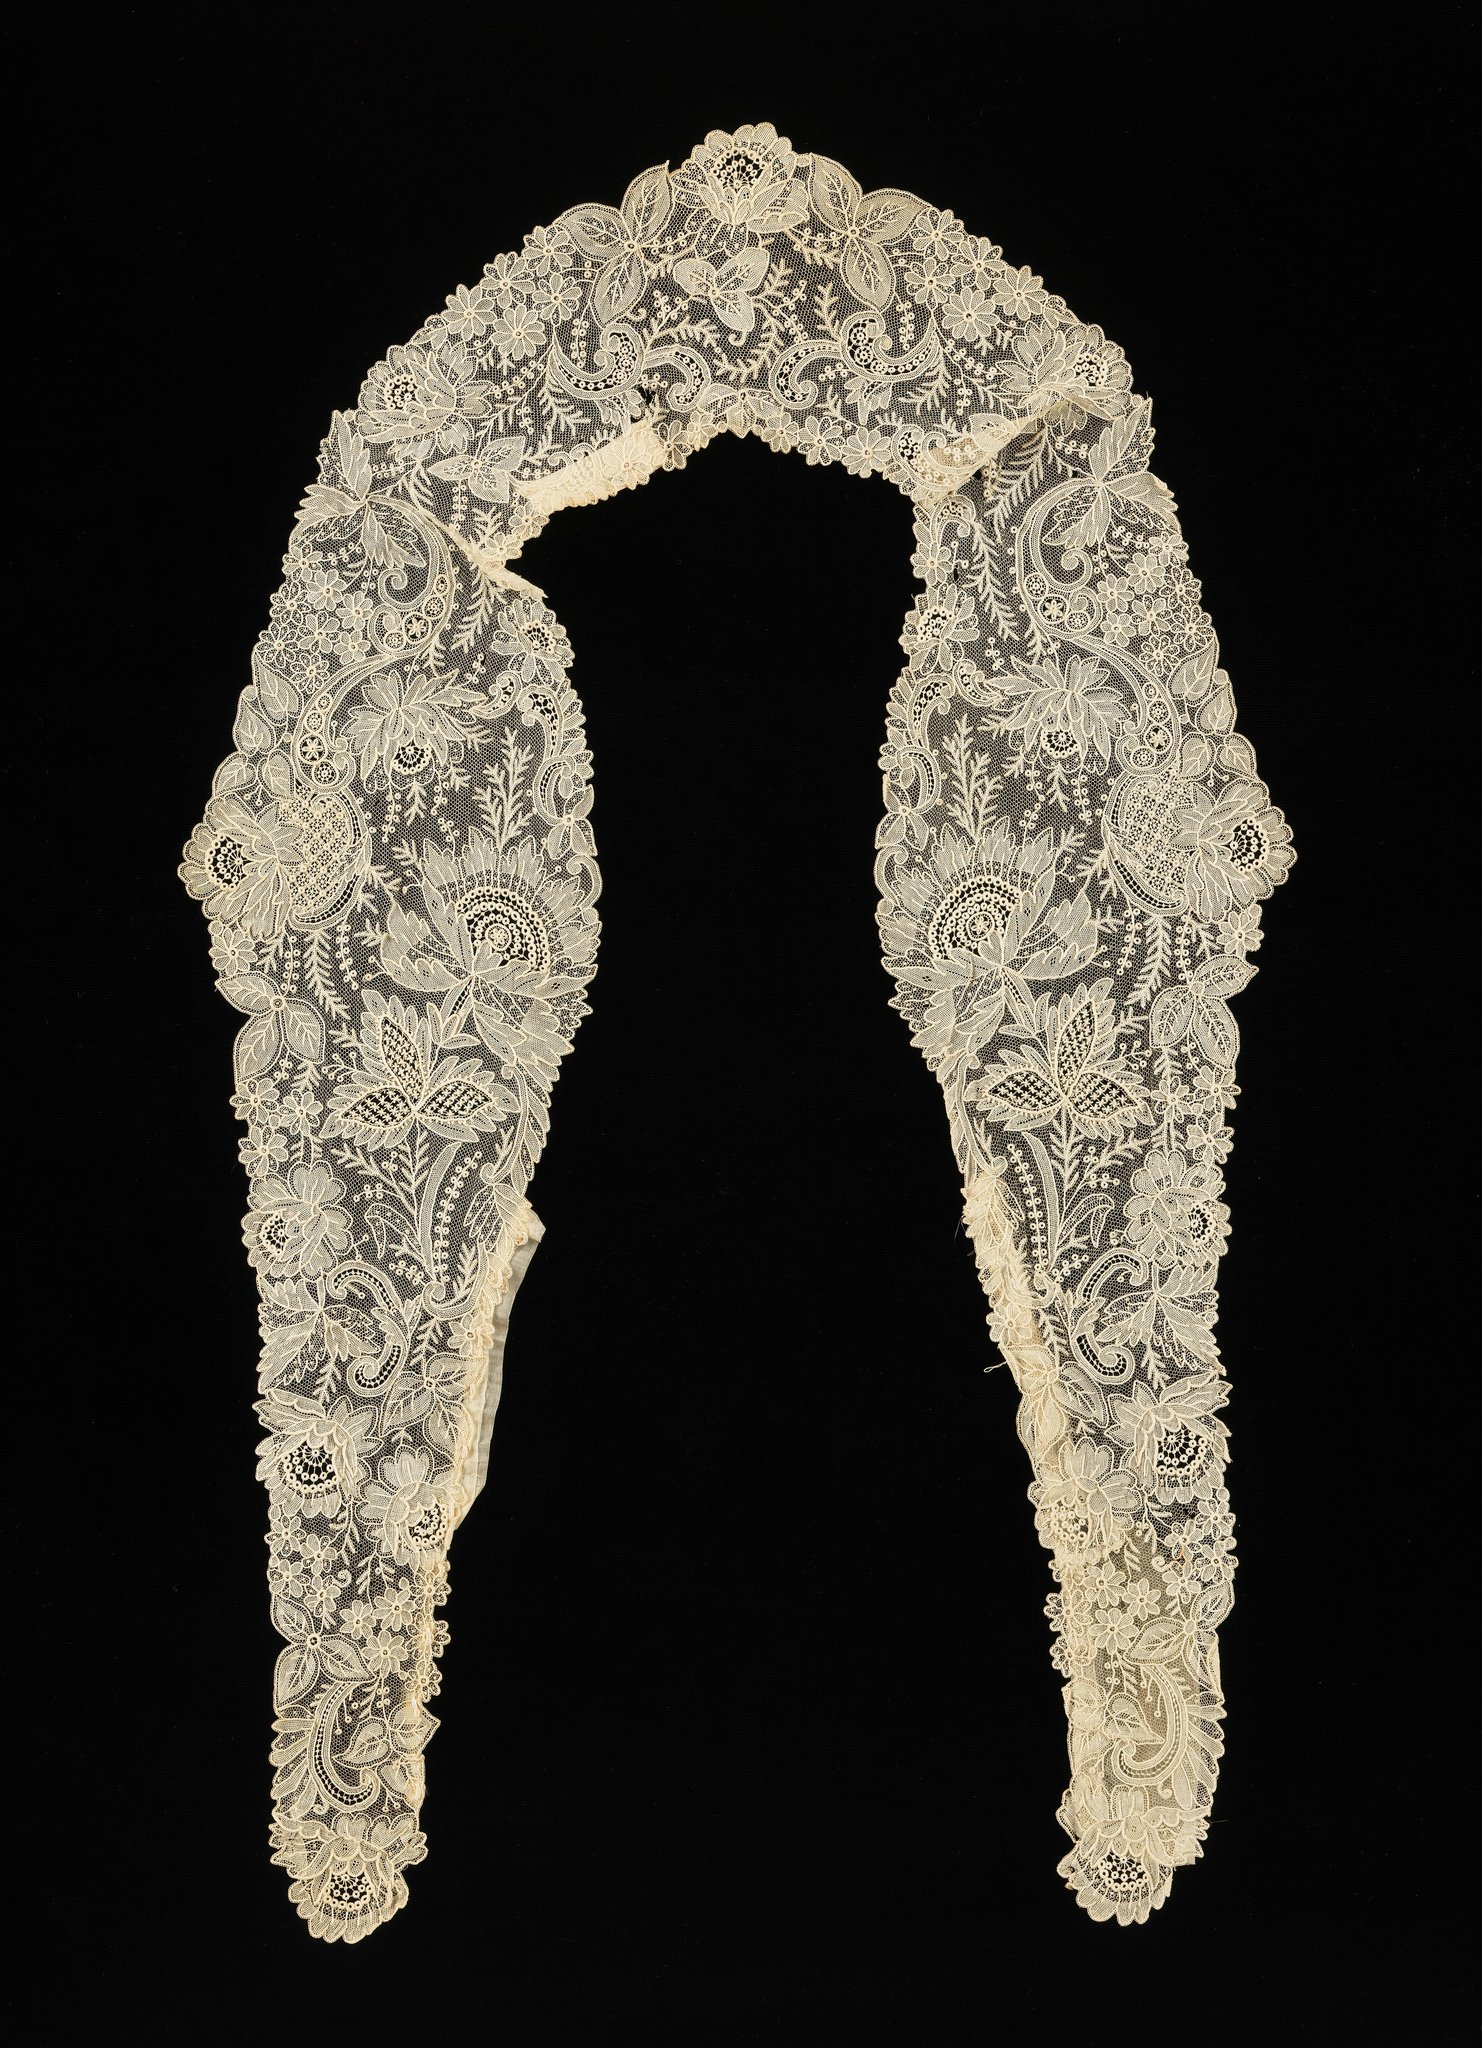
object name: neckpiece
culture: belgian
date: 1870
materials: linen